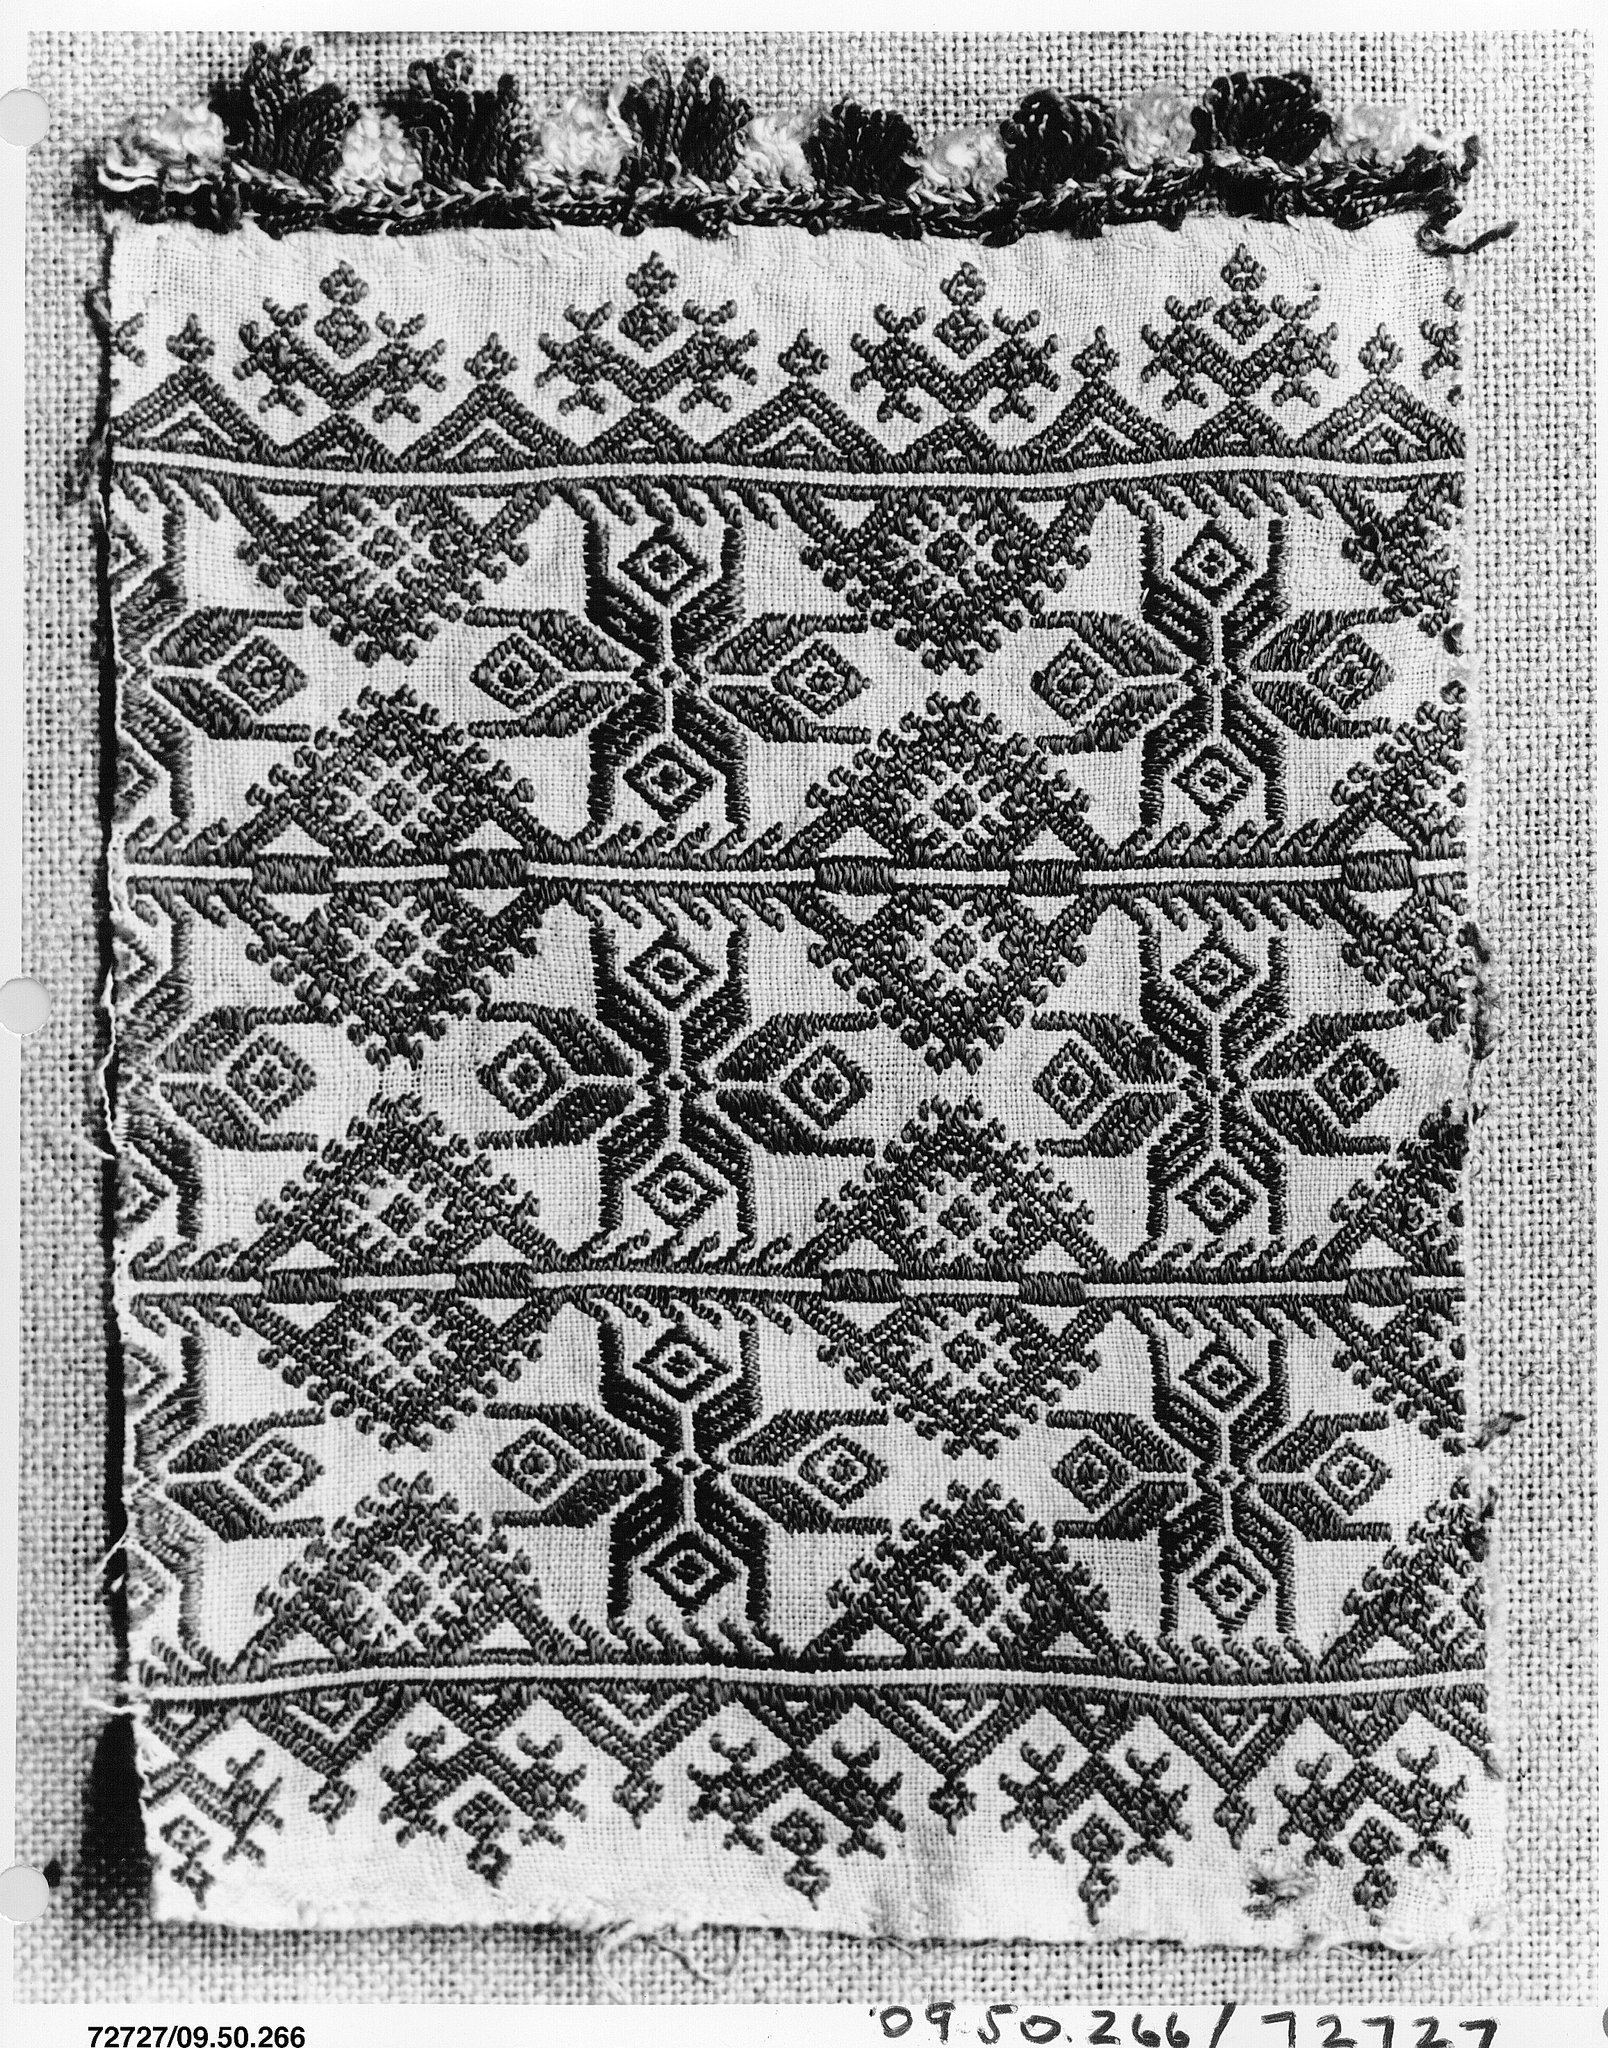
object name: band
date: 1701-1800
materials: linen, silk